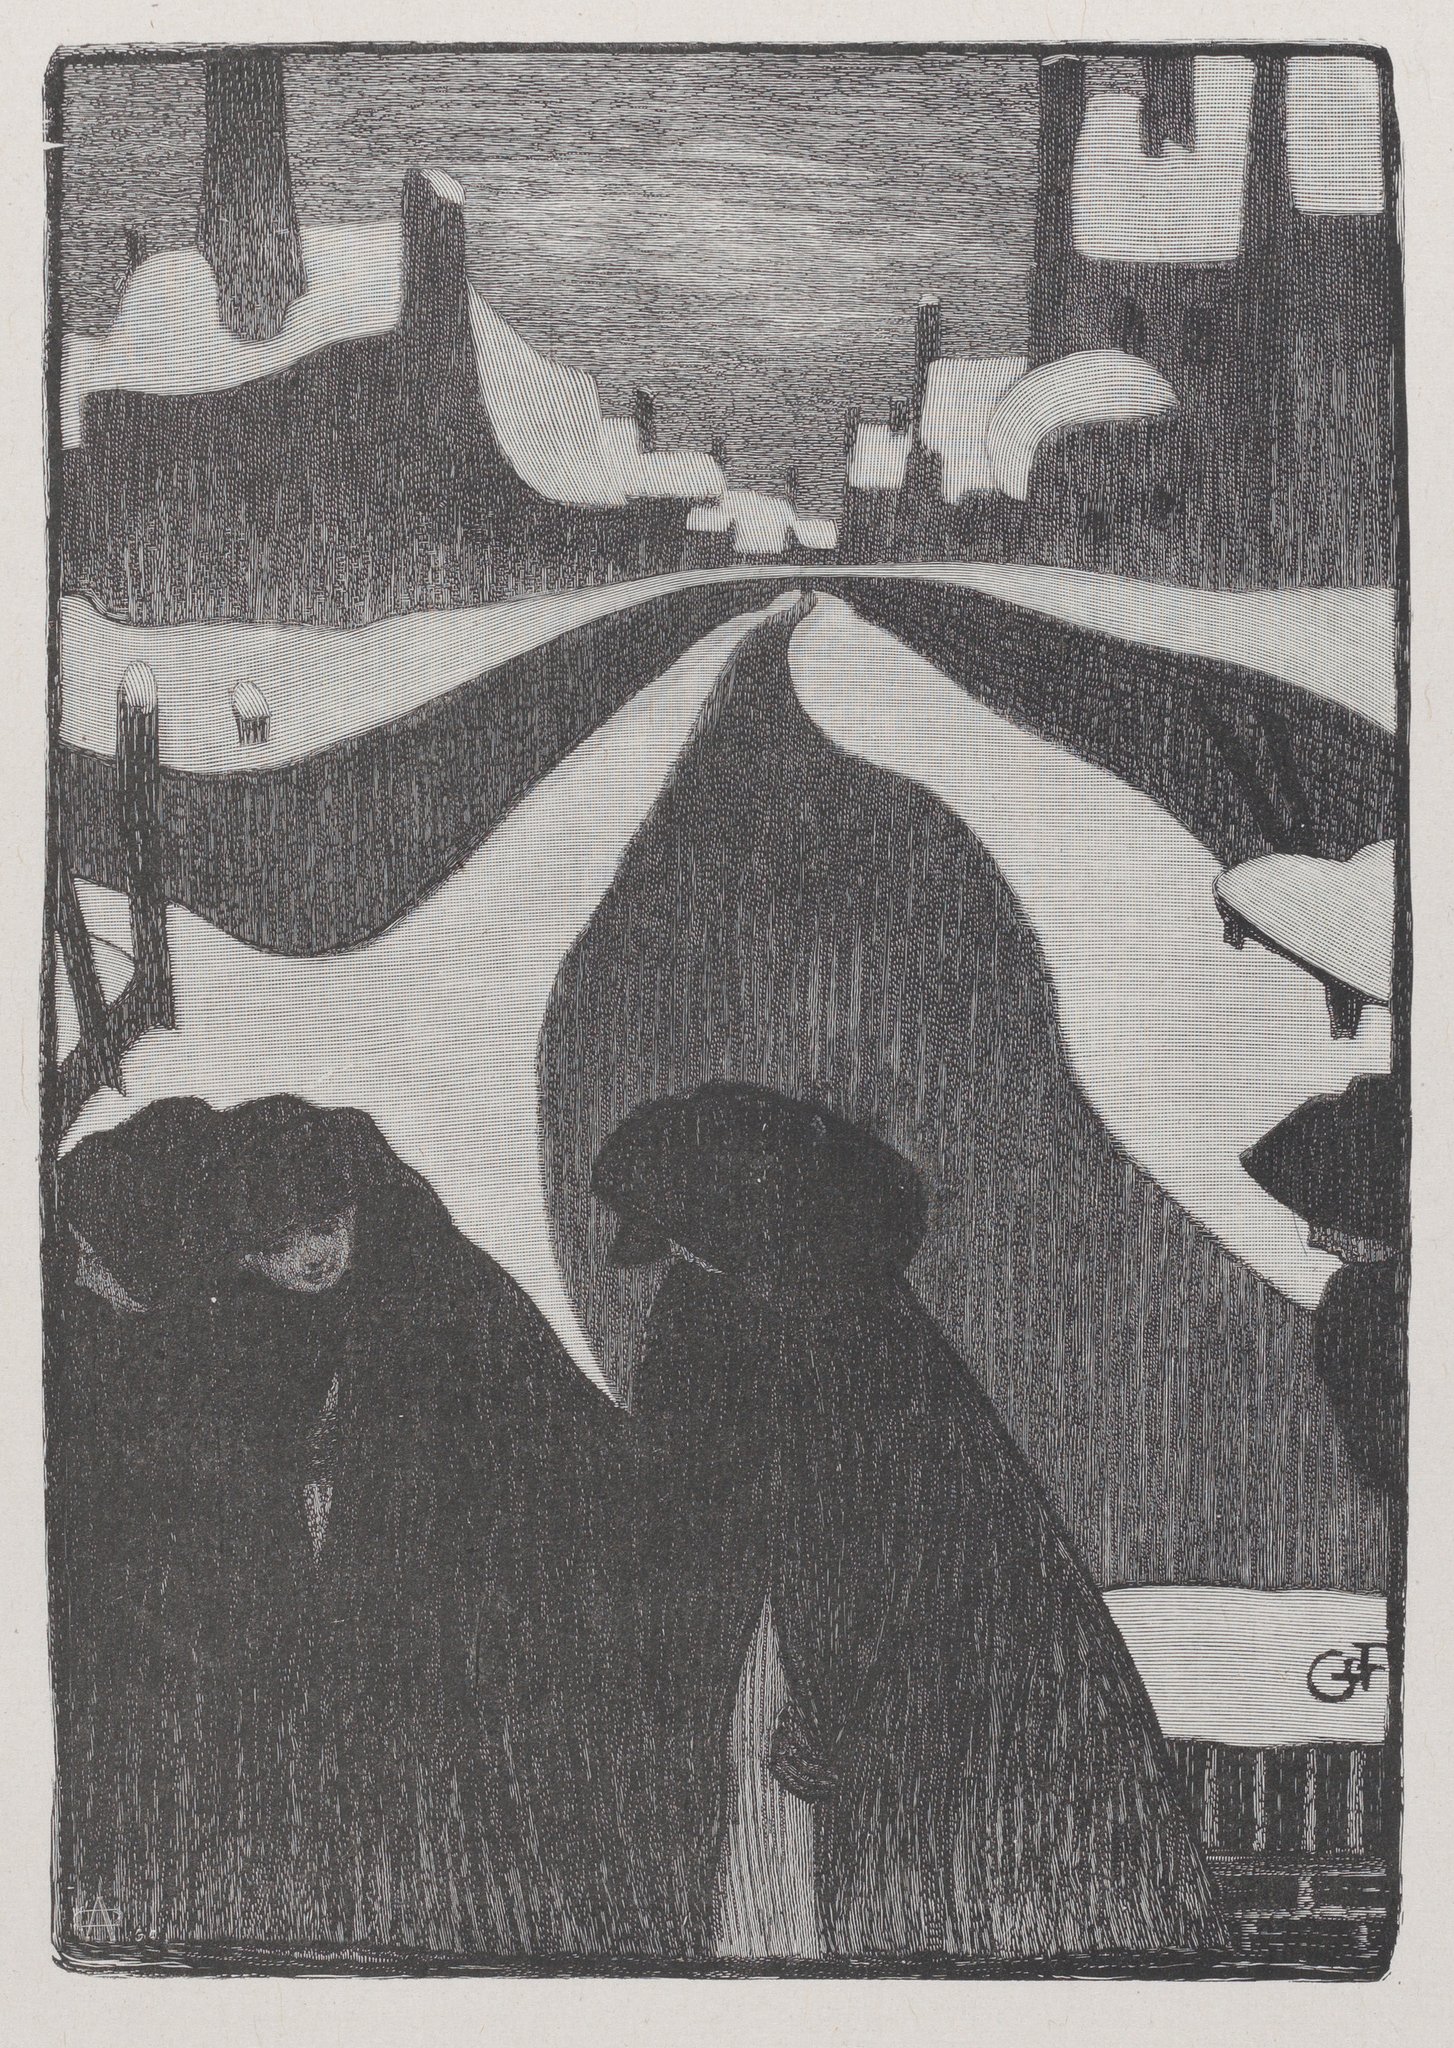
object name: print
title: Petits Nocturnes de Bruges, from "L'Image"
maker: adolphe dauvergne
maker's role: artist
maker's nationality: french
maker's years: 1865-1924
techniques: engraving